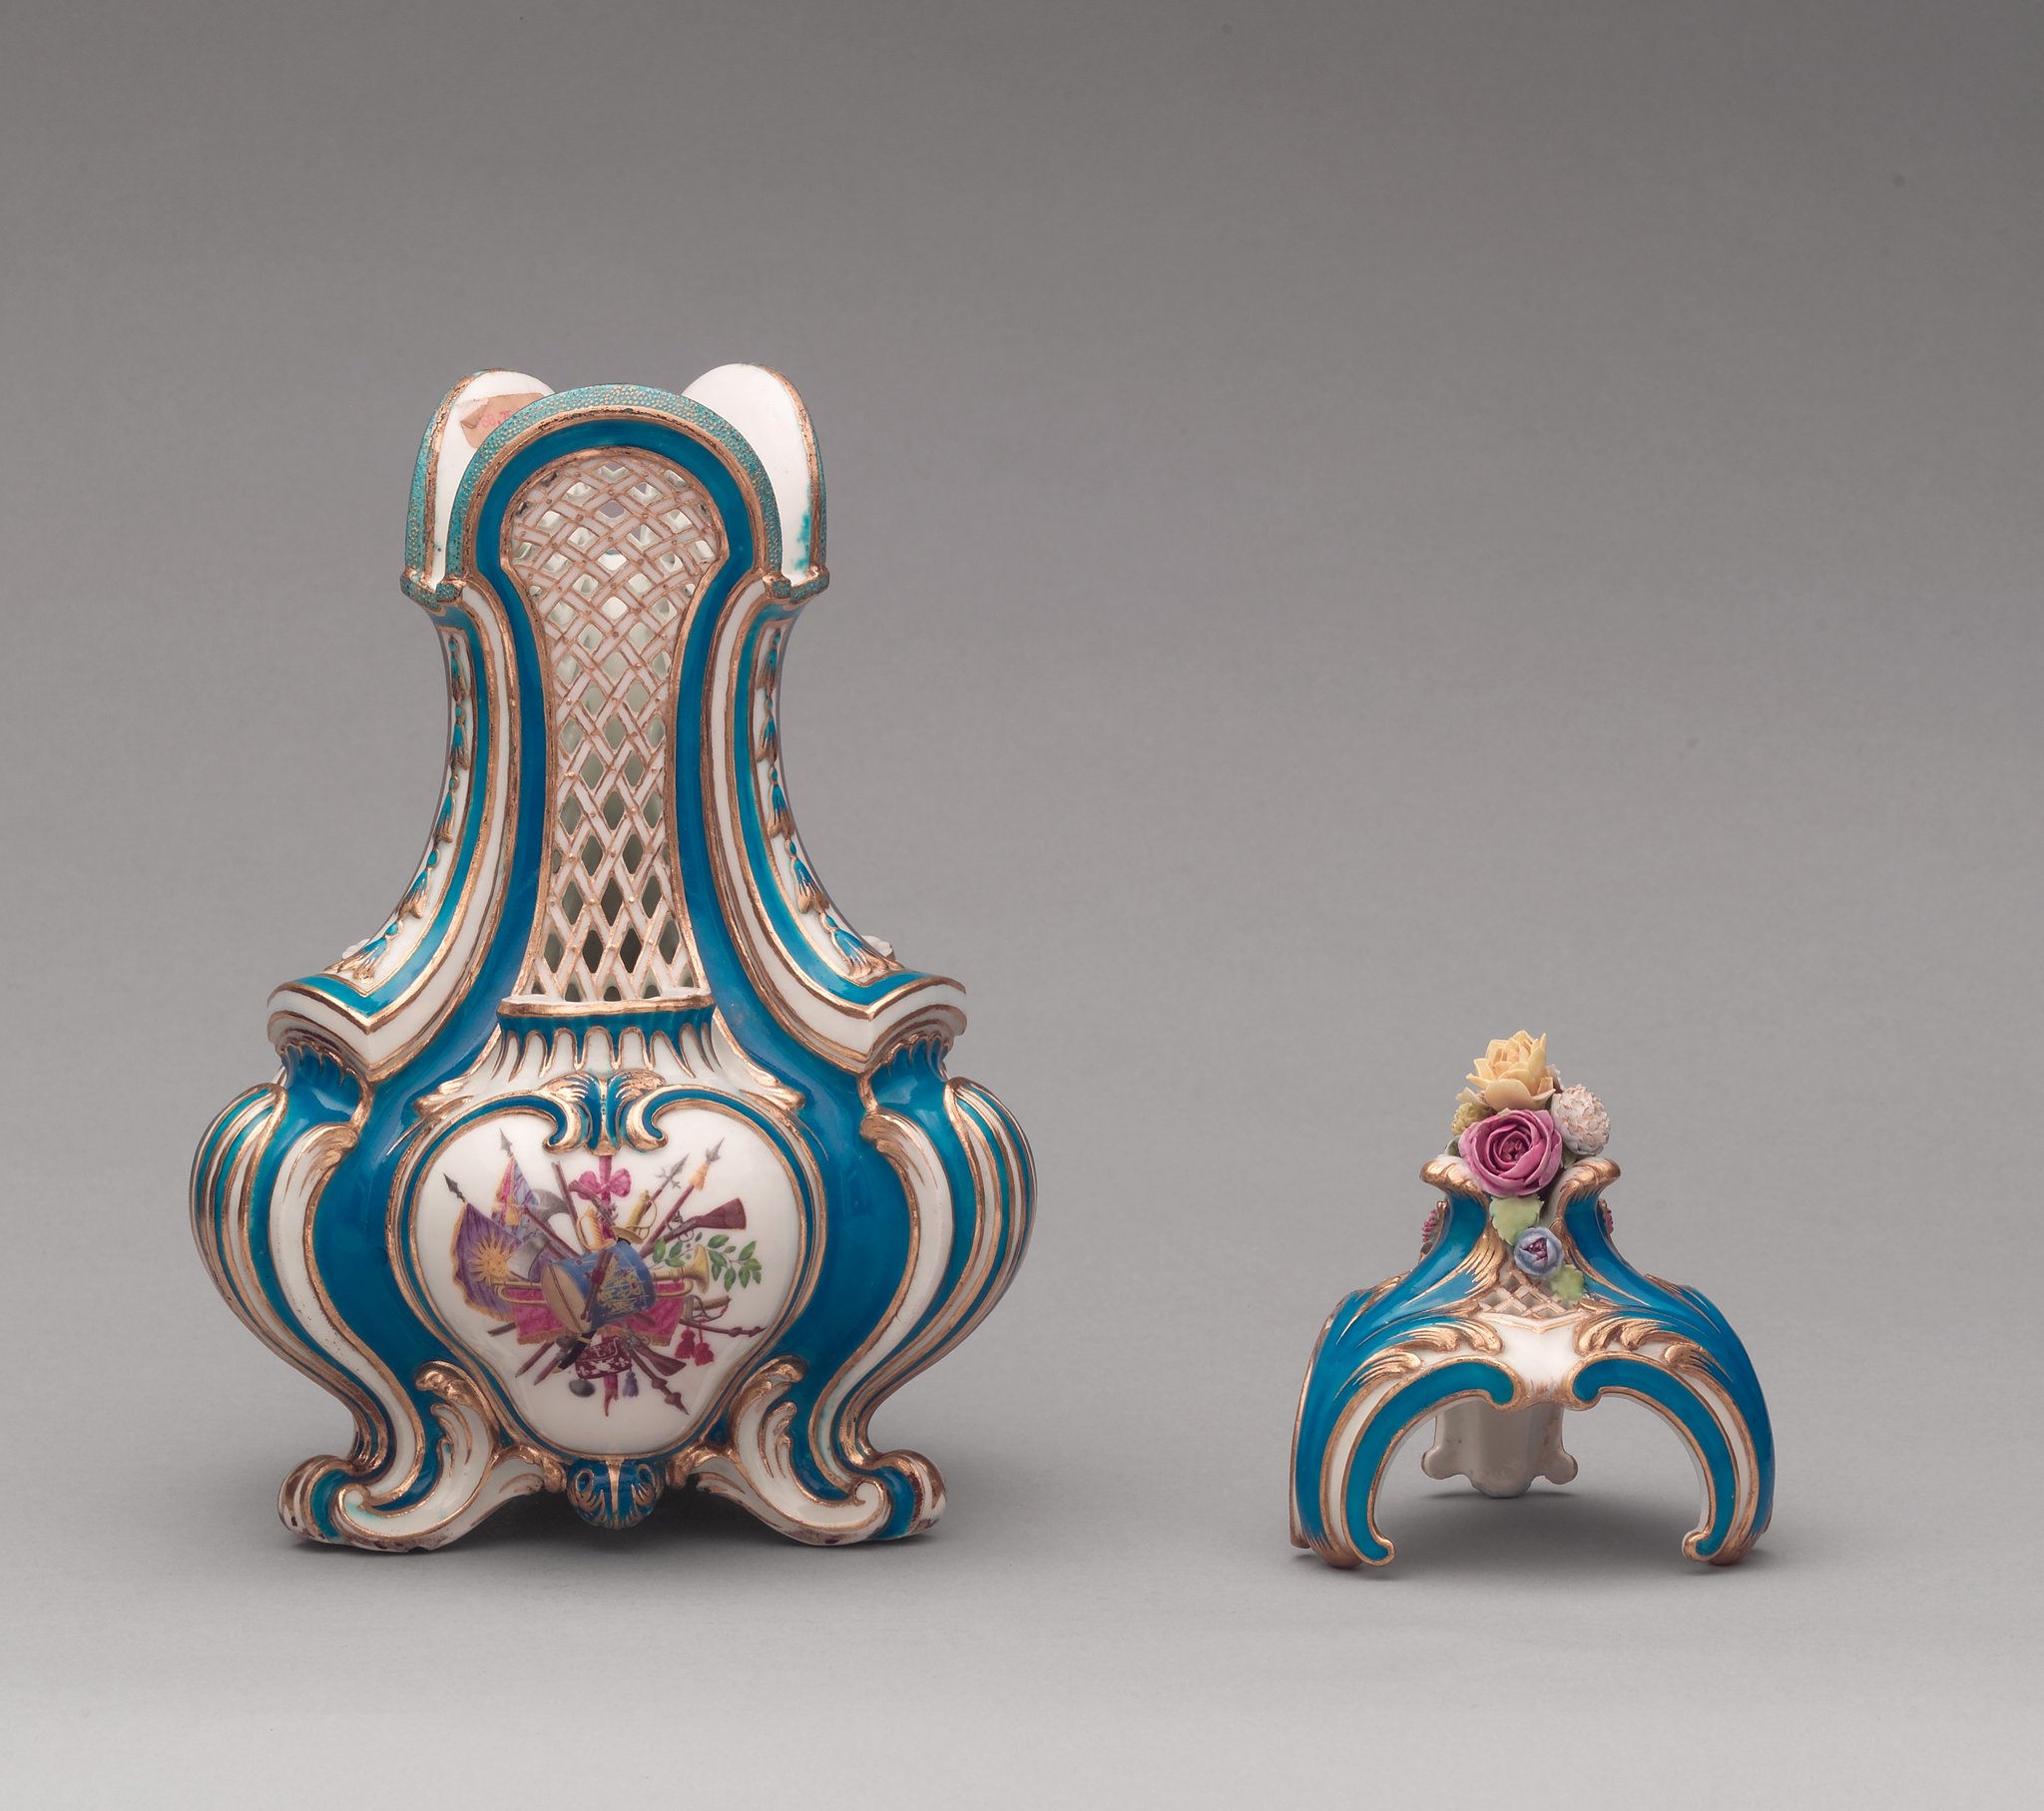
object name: vase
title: Vase with cover (vase pot-pourri triangle) (one of a pair)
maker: sèvres manufactory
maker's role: manufactory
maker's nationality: french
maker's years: 1740-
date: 1761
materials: soft paste porcelain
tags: musical instruments,firearms,flags